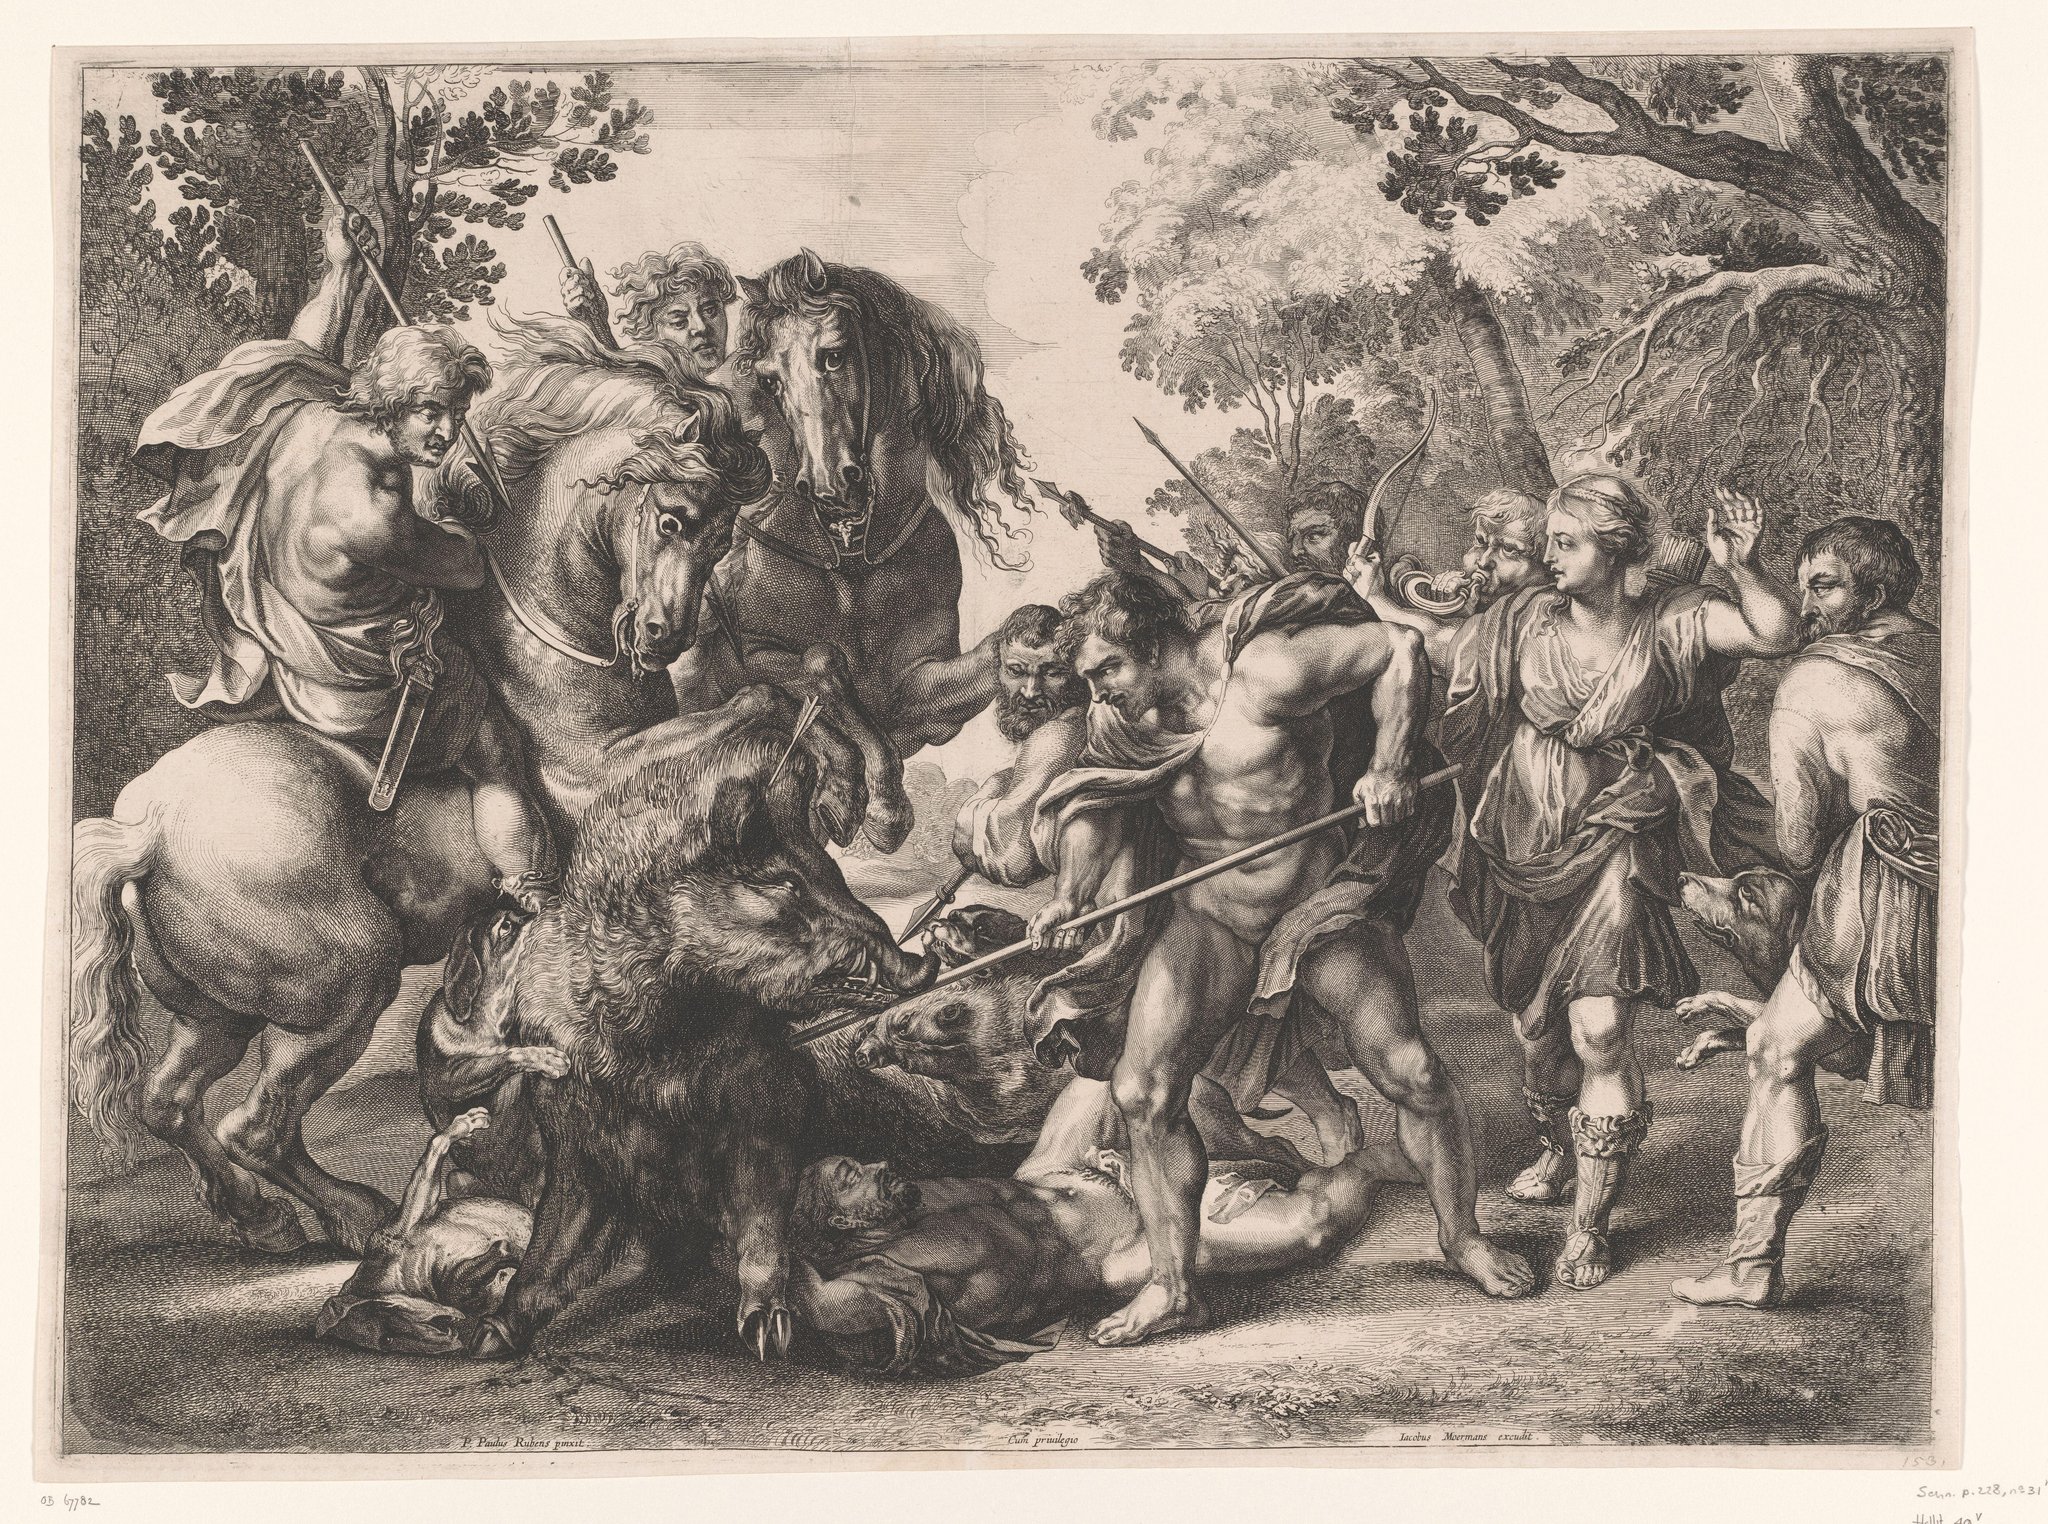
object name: print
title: Jacht op het Calydonische zwijn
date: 1630-1653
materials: paper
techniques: engraving, etching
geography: antwerp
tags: the wild boar is killed, usually by meleager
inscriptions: collector's mark: Lugt 240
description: Meleager doodt het Calydonische zwijn met een lans. Hij is omringd door honden en jagers die toekijken hoe zijn lans het beest doorboort.